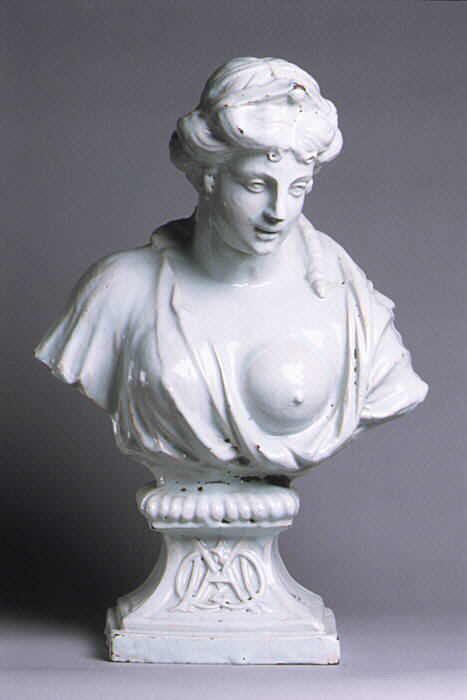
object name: bust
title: Bust of Cleopatra (one of a pair)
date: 1720-1730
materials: earthenware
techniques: glazing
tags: cleopatra,female nudes